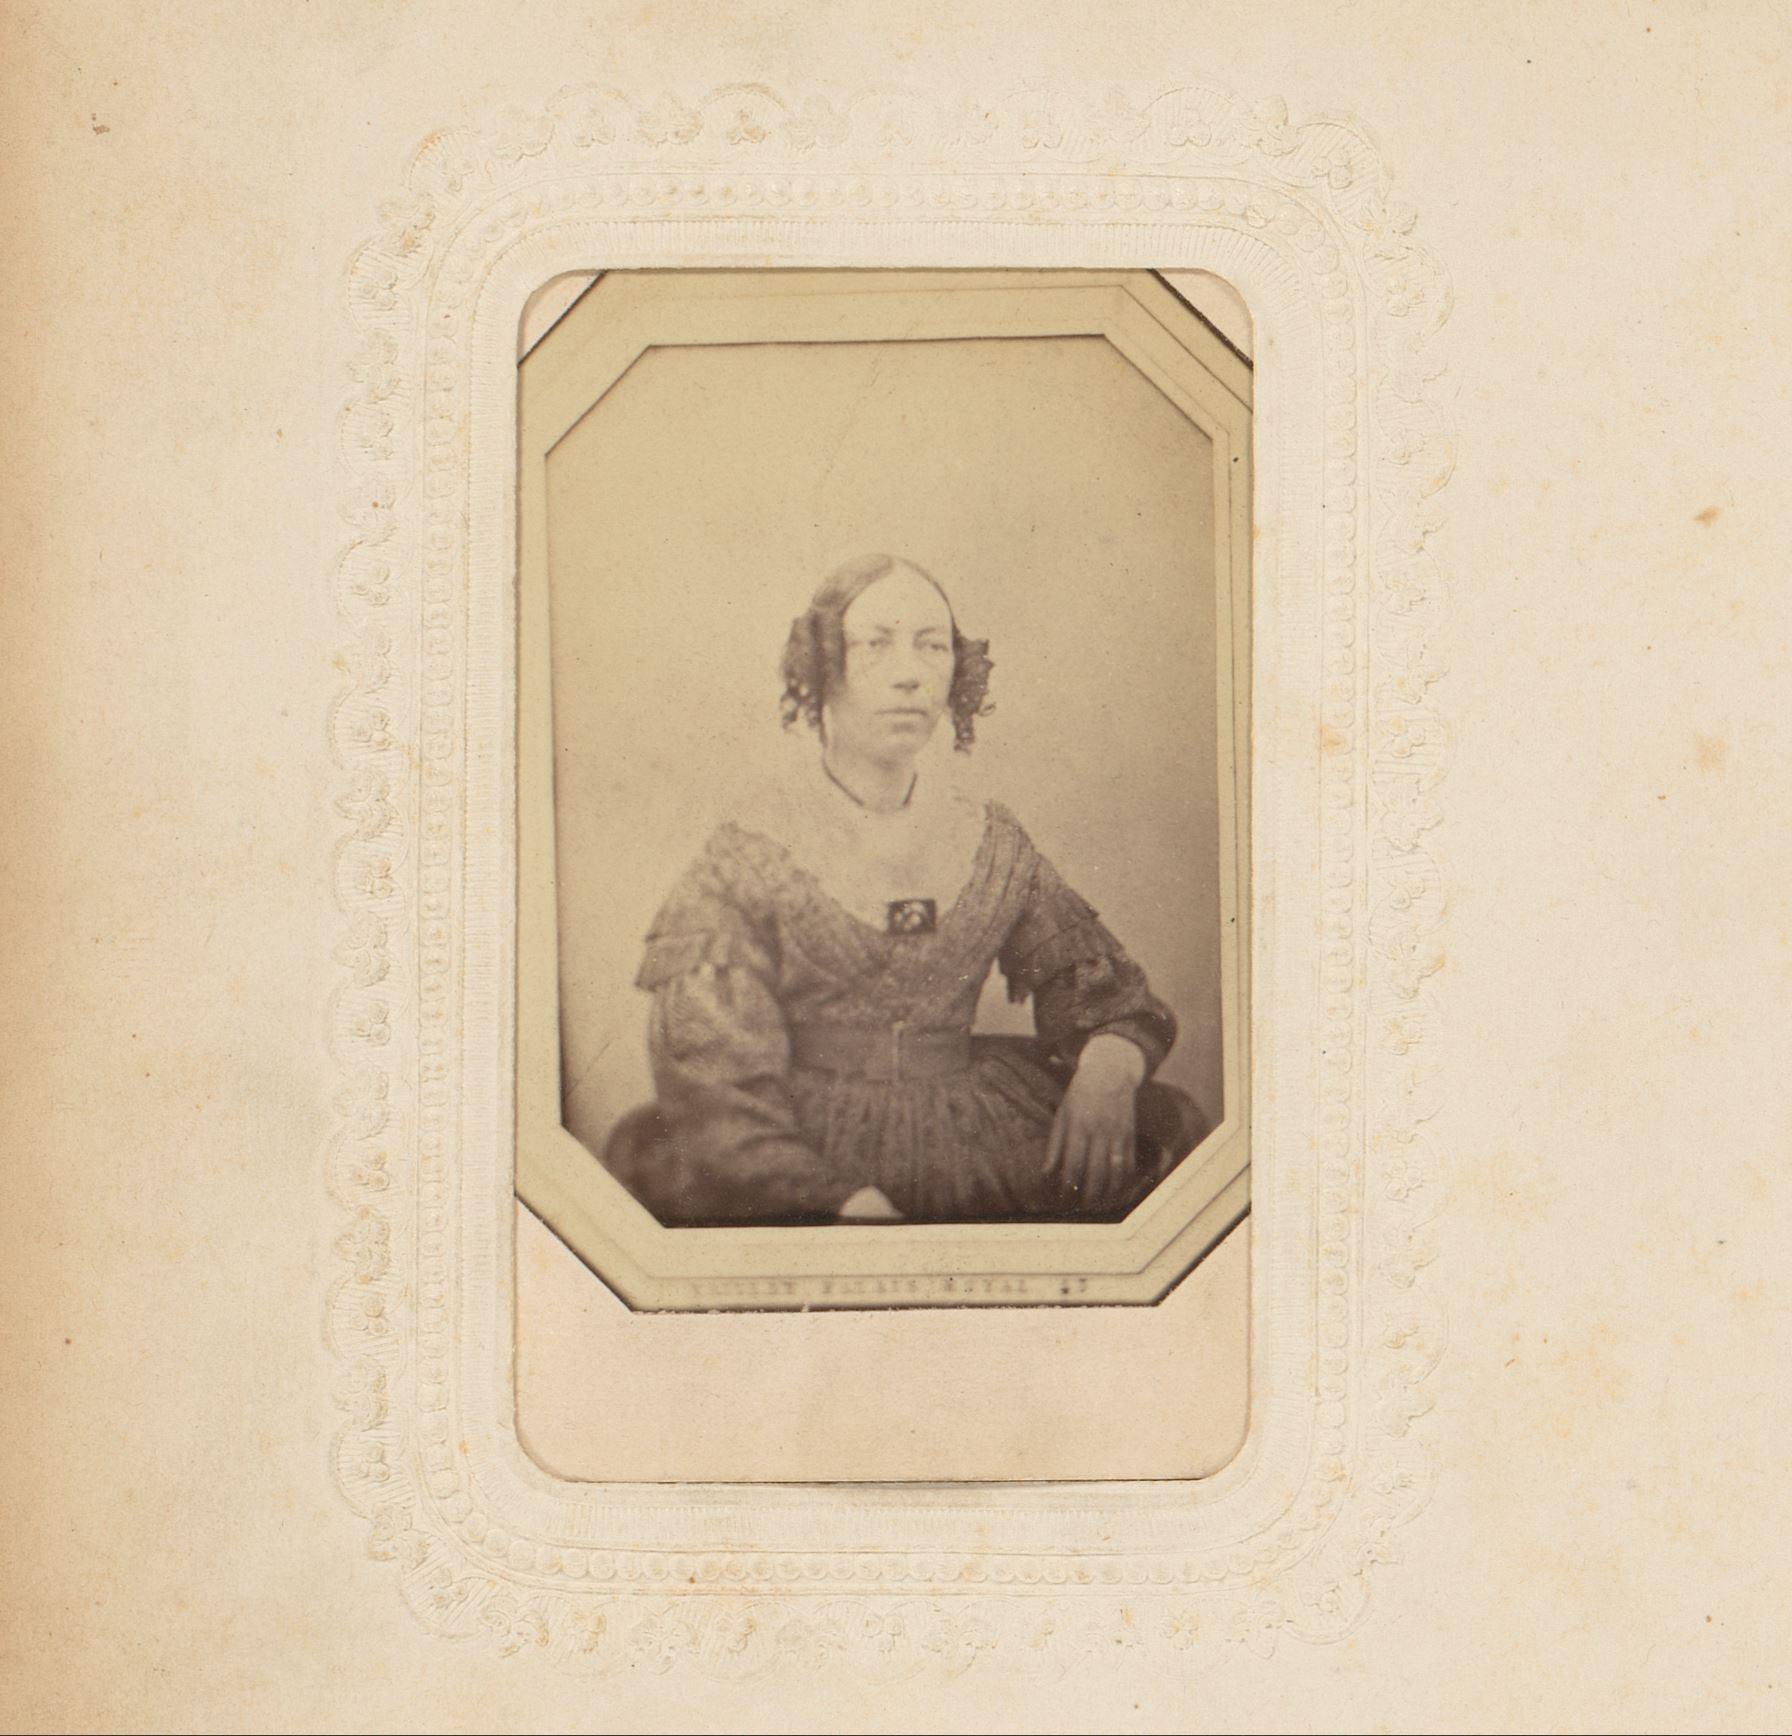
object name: photograph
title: Portret van een zittende vrouw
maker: Anonymous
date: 1860-1890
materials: cardboard, photographic support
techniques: albumen print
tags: sitting figure - aa - female human figure, historical persons - bb - woman